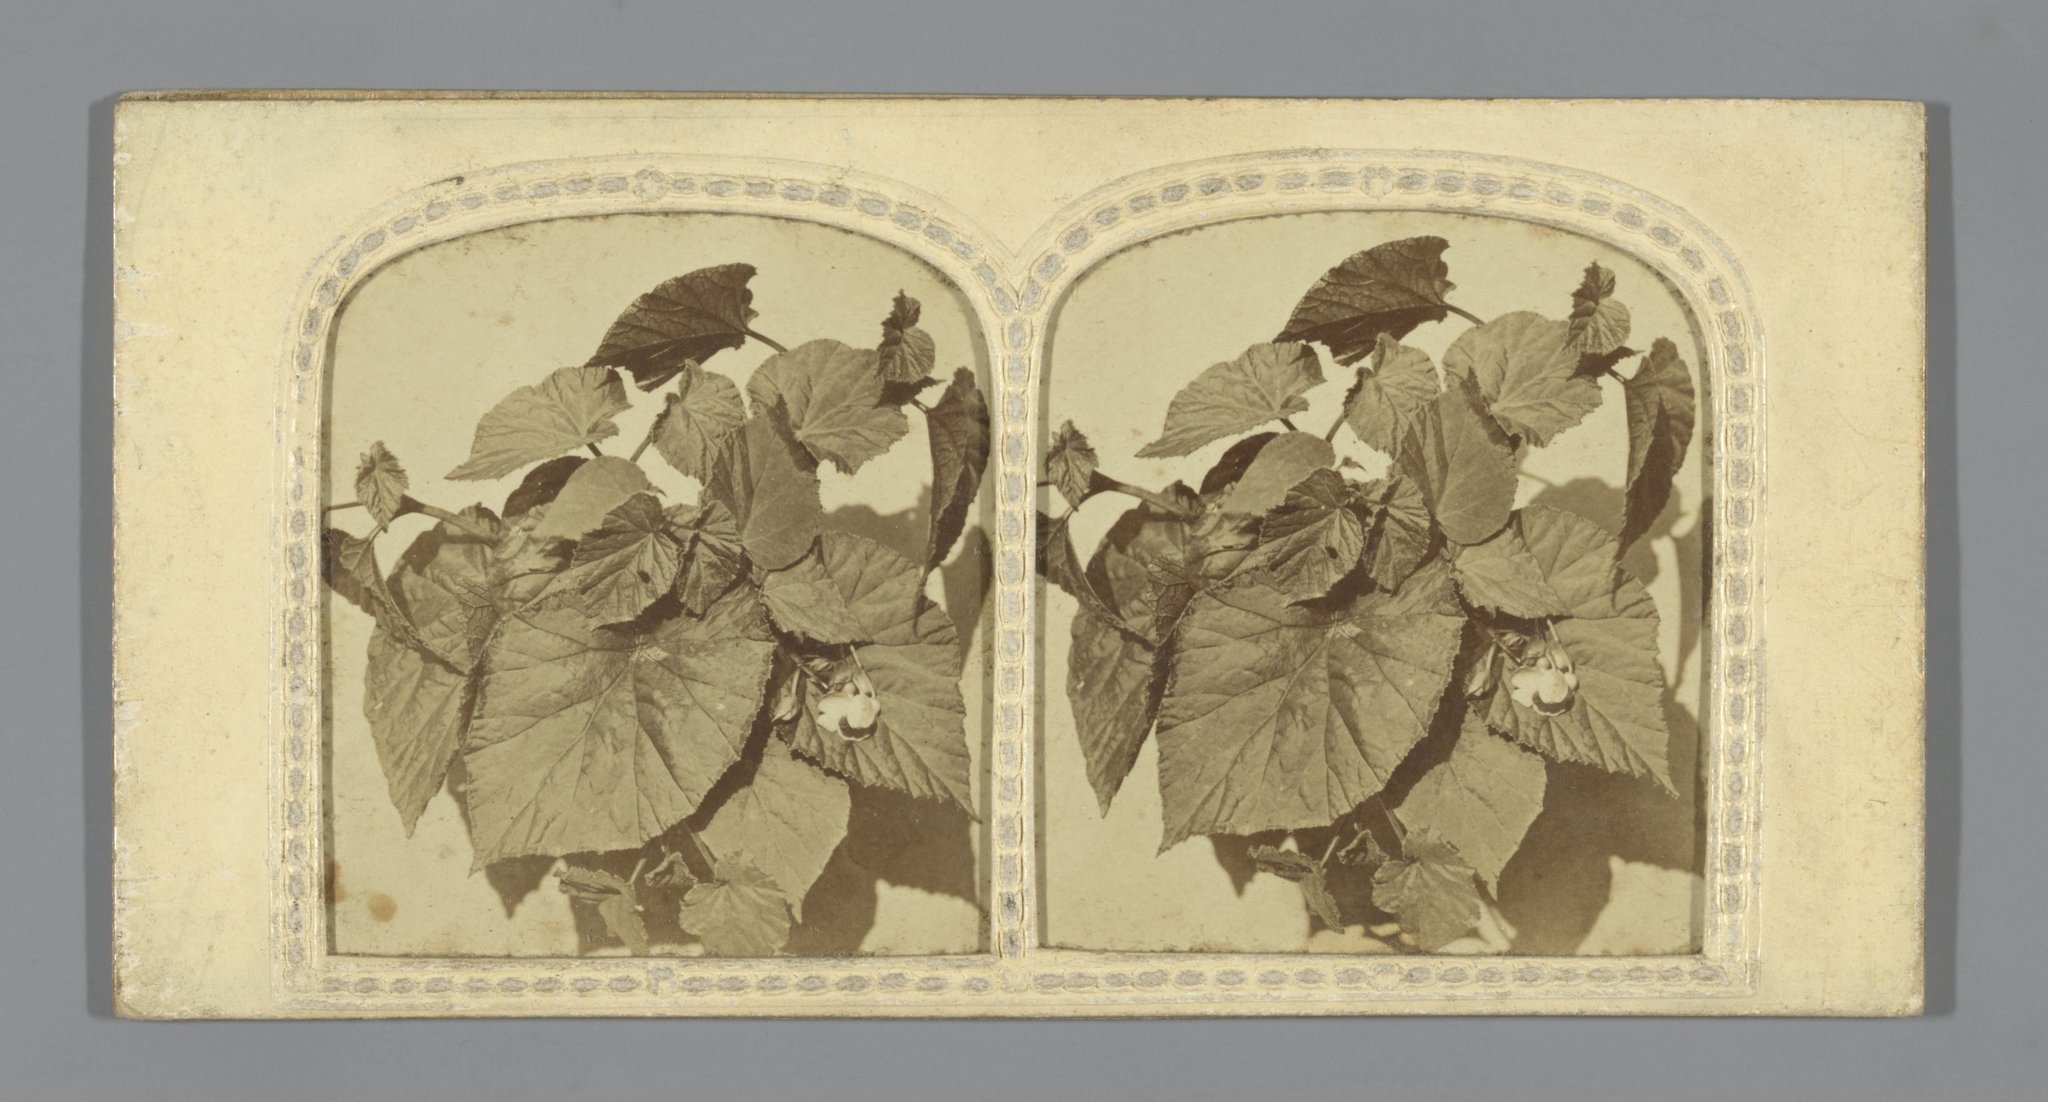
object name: tissue stereograph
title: Stilleven met plant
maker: Anonymous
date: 1855-1875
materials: cardboard, paper, photographic support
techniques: albumen print, hand coloring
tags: plants (in general)